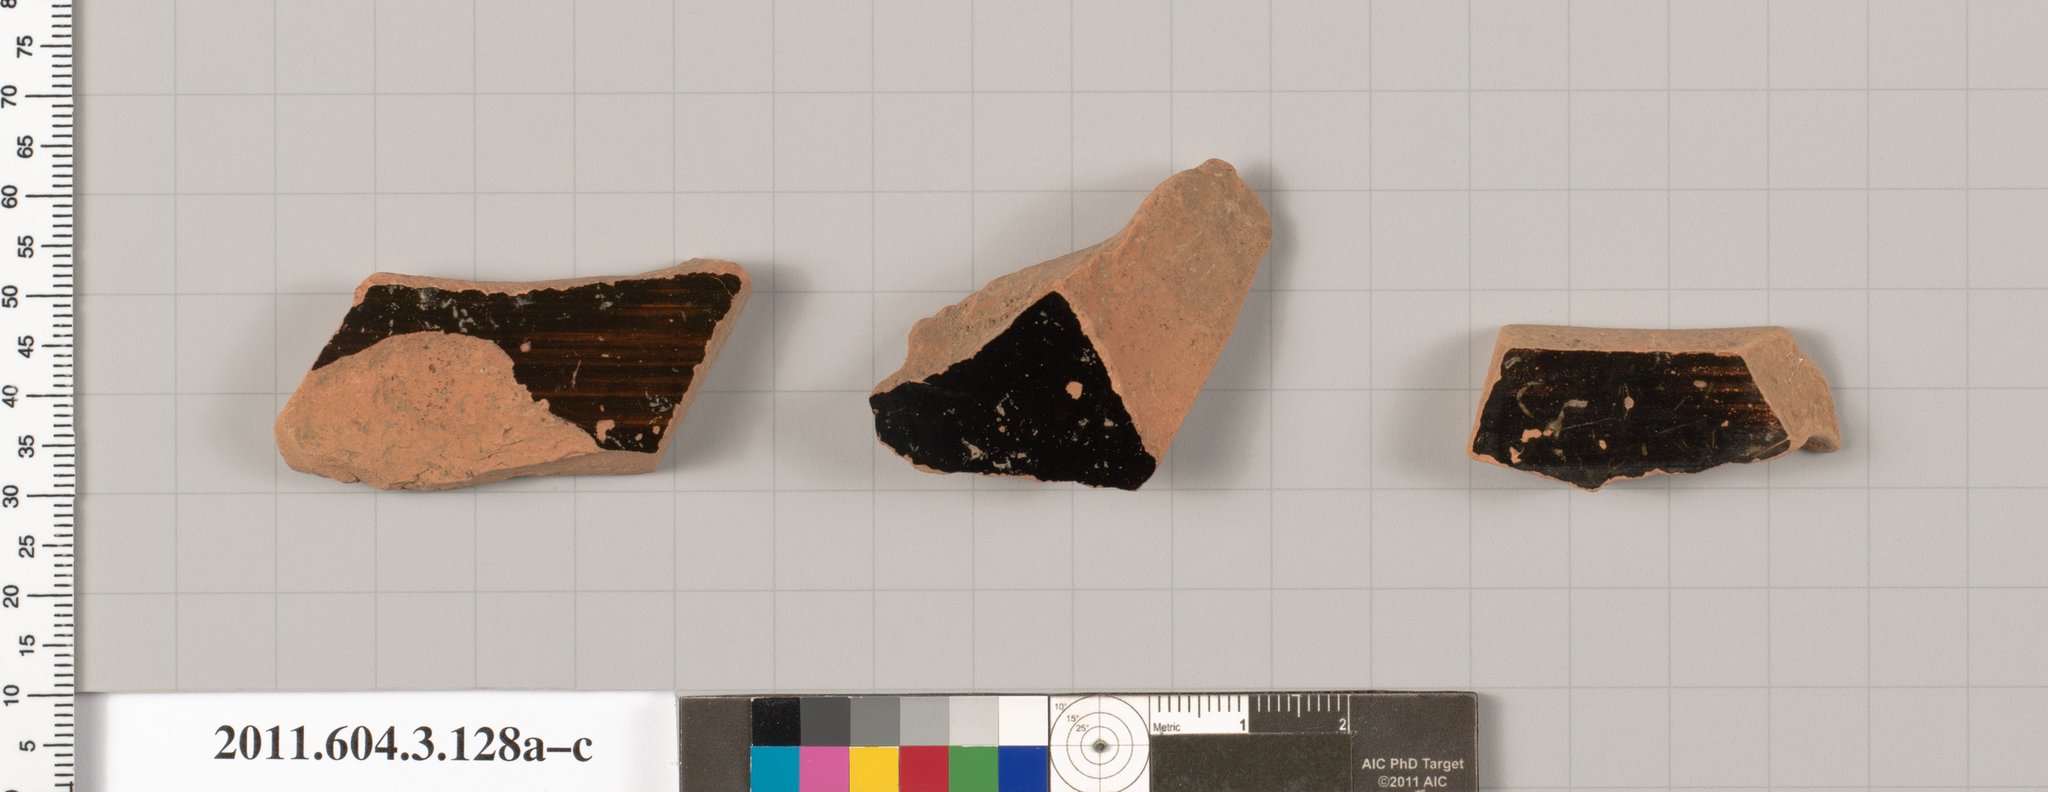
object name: amphora fragment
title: Terracotta fragments of amphorae (jars)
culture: greek, attic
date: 600-468 BCE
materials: terracotta